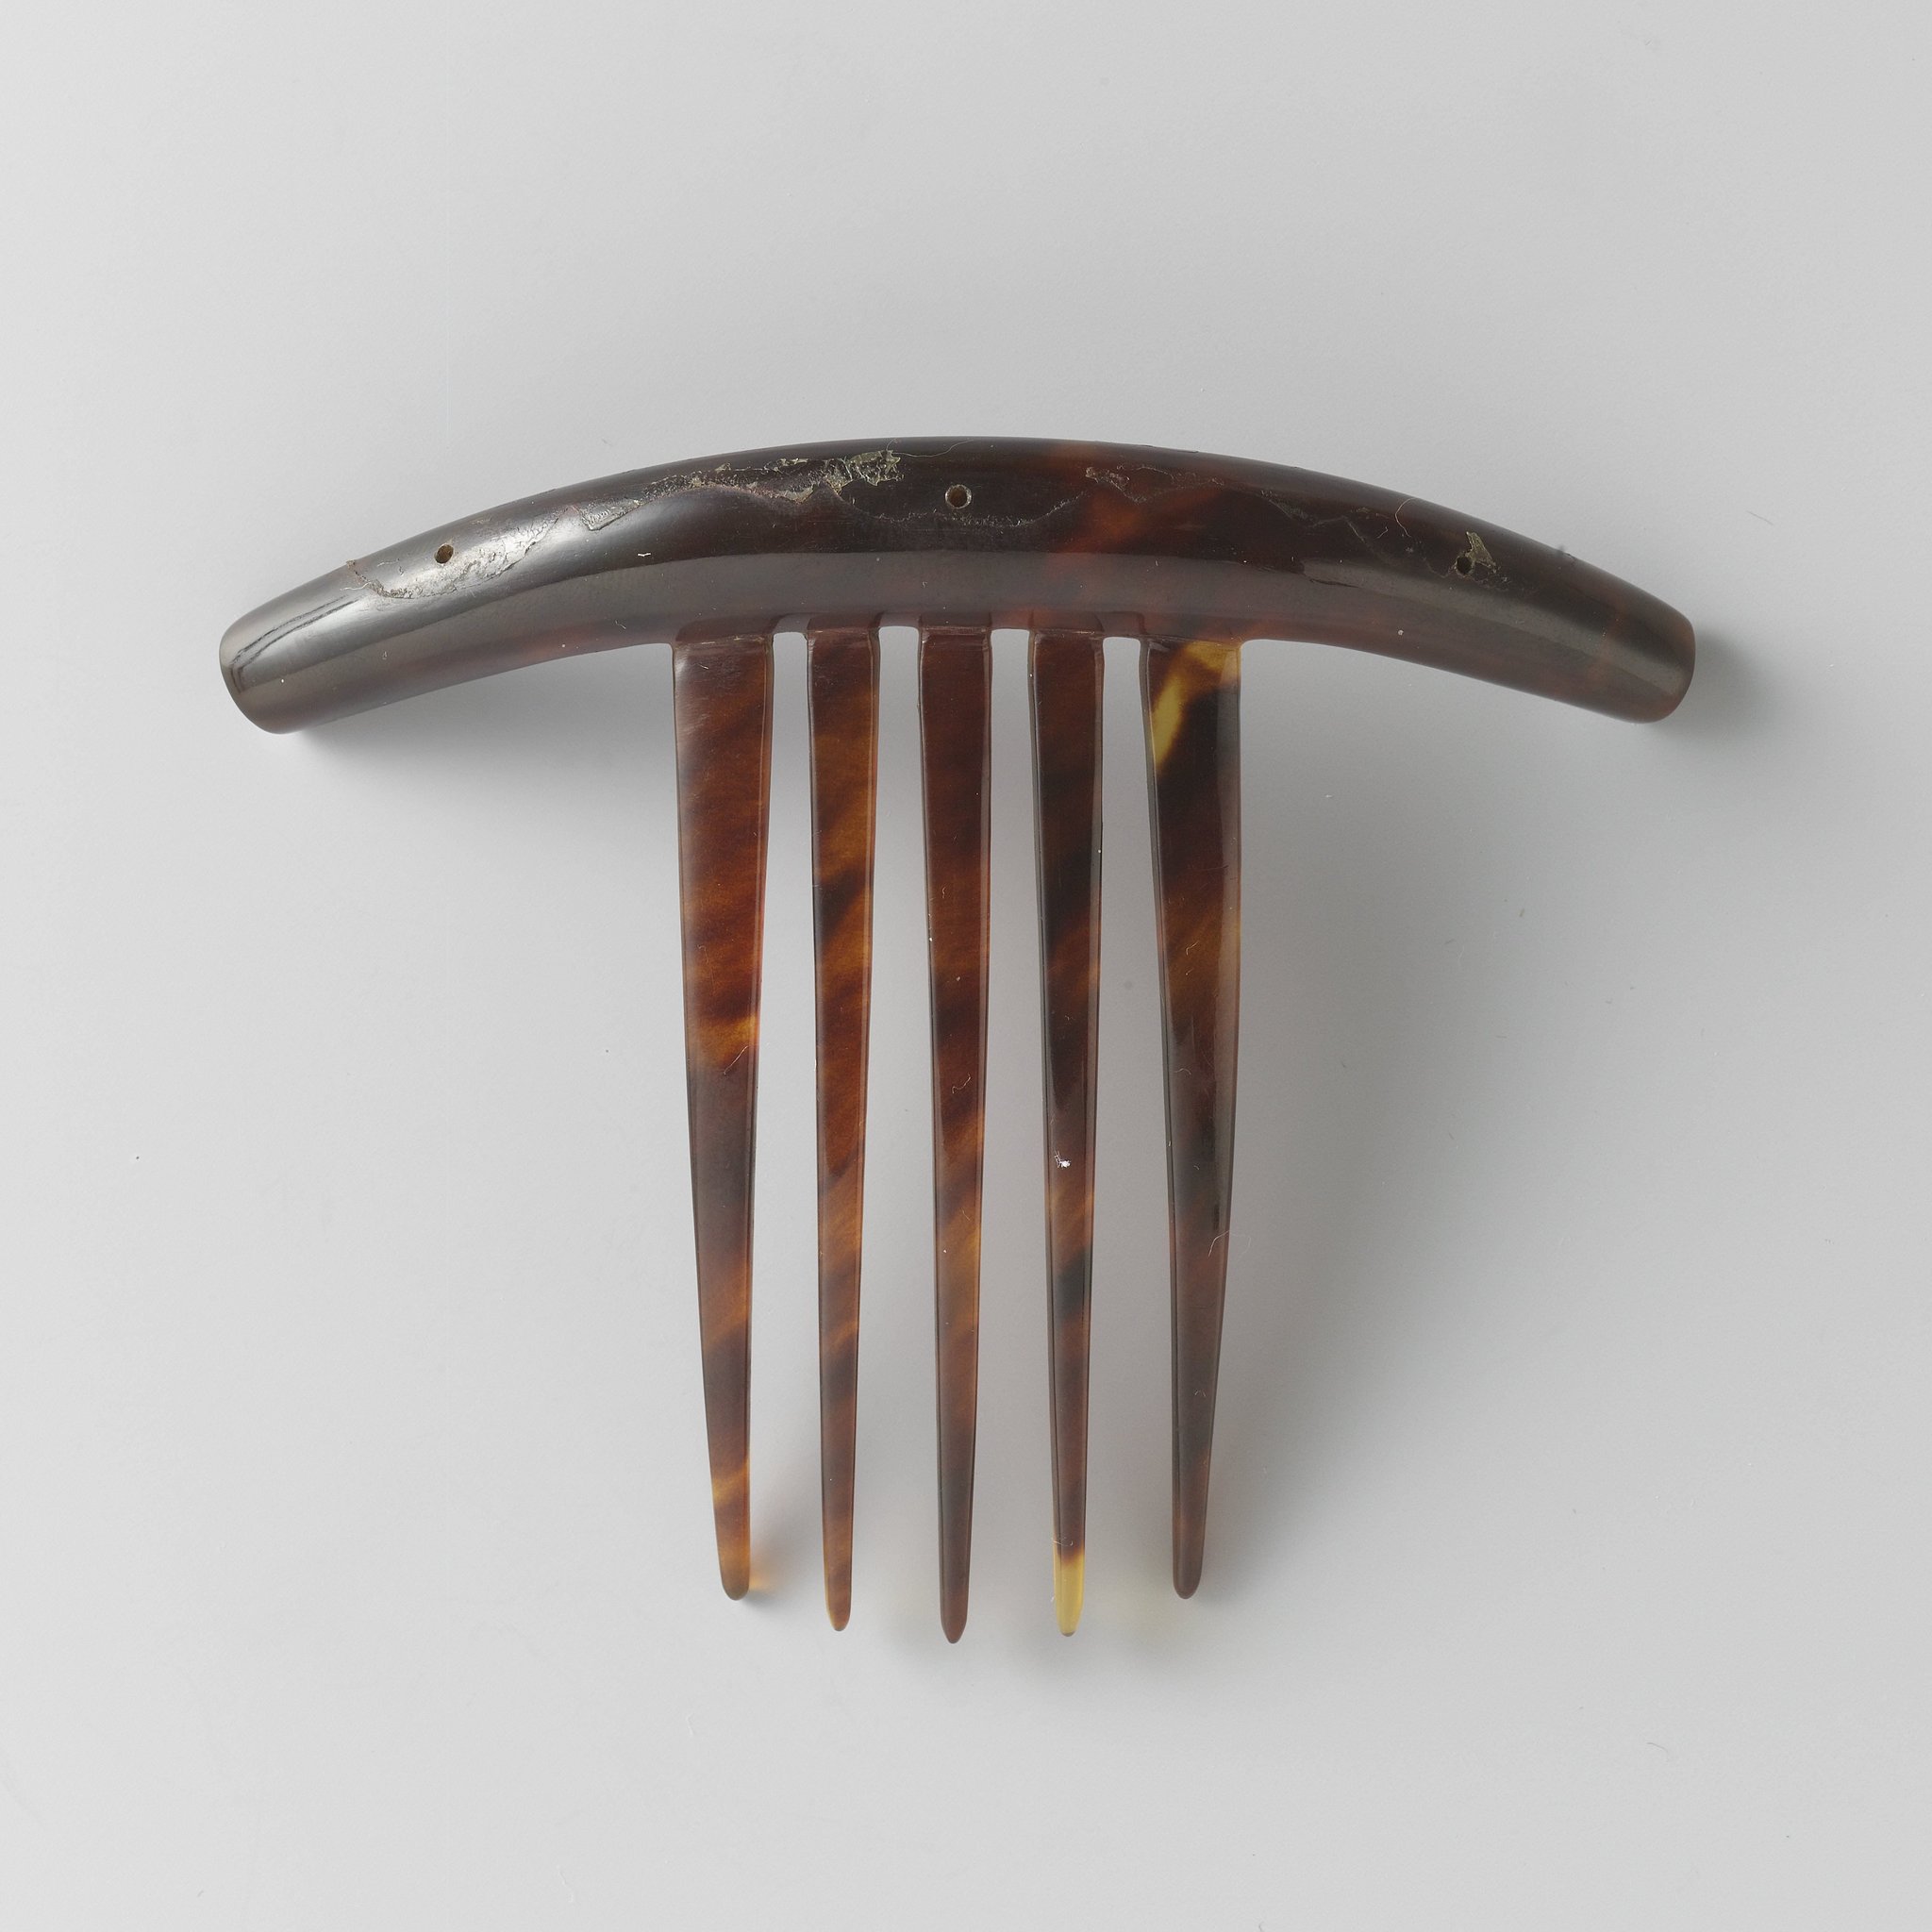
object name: comb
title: Haarkam van schildpad met smalle, onversierde gebogen rug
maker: Anonymous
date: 1885-1900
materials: shell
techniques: assembly, filing, polish, pressing, sawing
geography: netherlands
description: Haarkam van schildpad met smalle, onversierde gebogen rug. Vijf tanden.